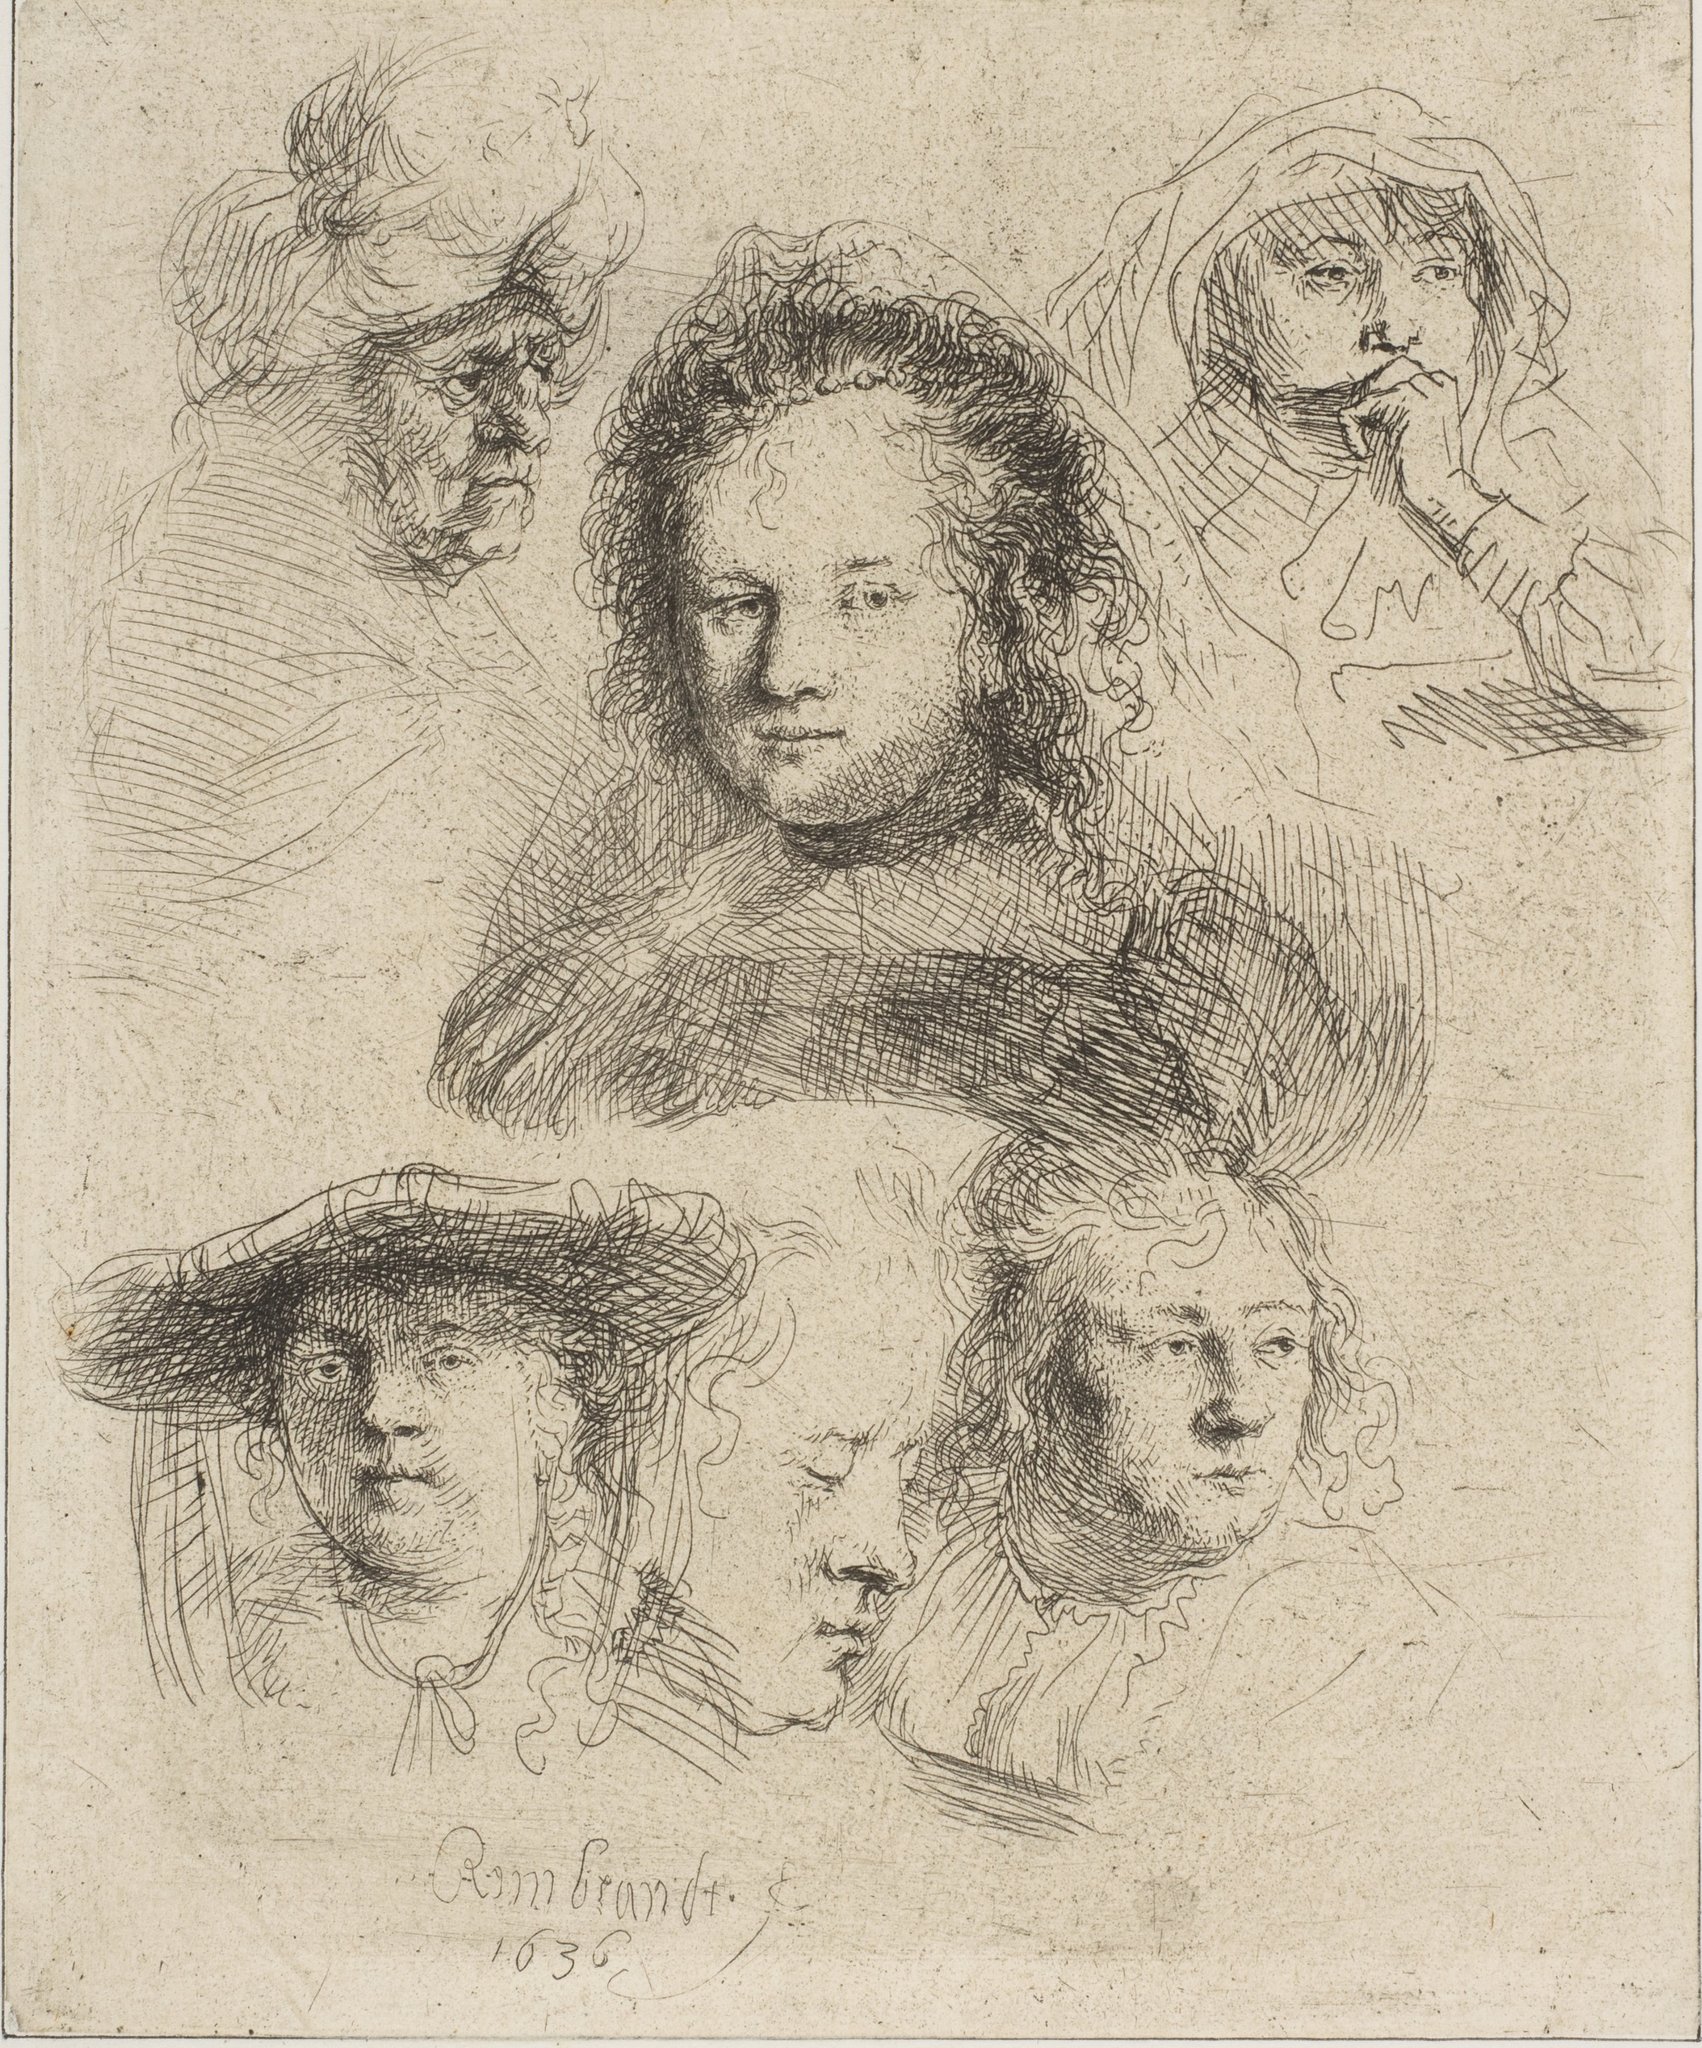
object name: print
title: Rembrandt's Wife and Five Other Heads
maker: rembrandt van rijn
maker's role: artist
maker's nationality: dutch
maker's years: 1606-1669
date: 1636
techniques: etching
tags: heads,men,portraits,profiles,women